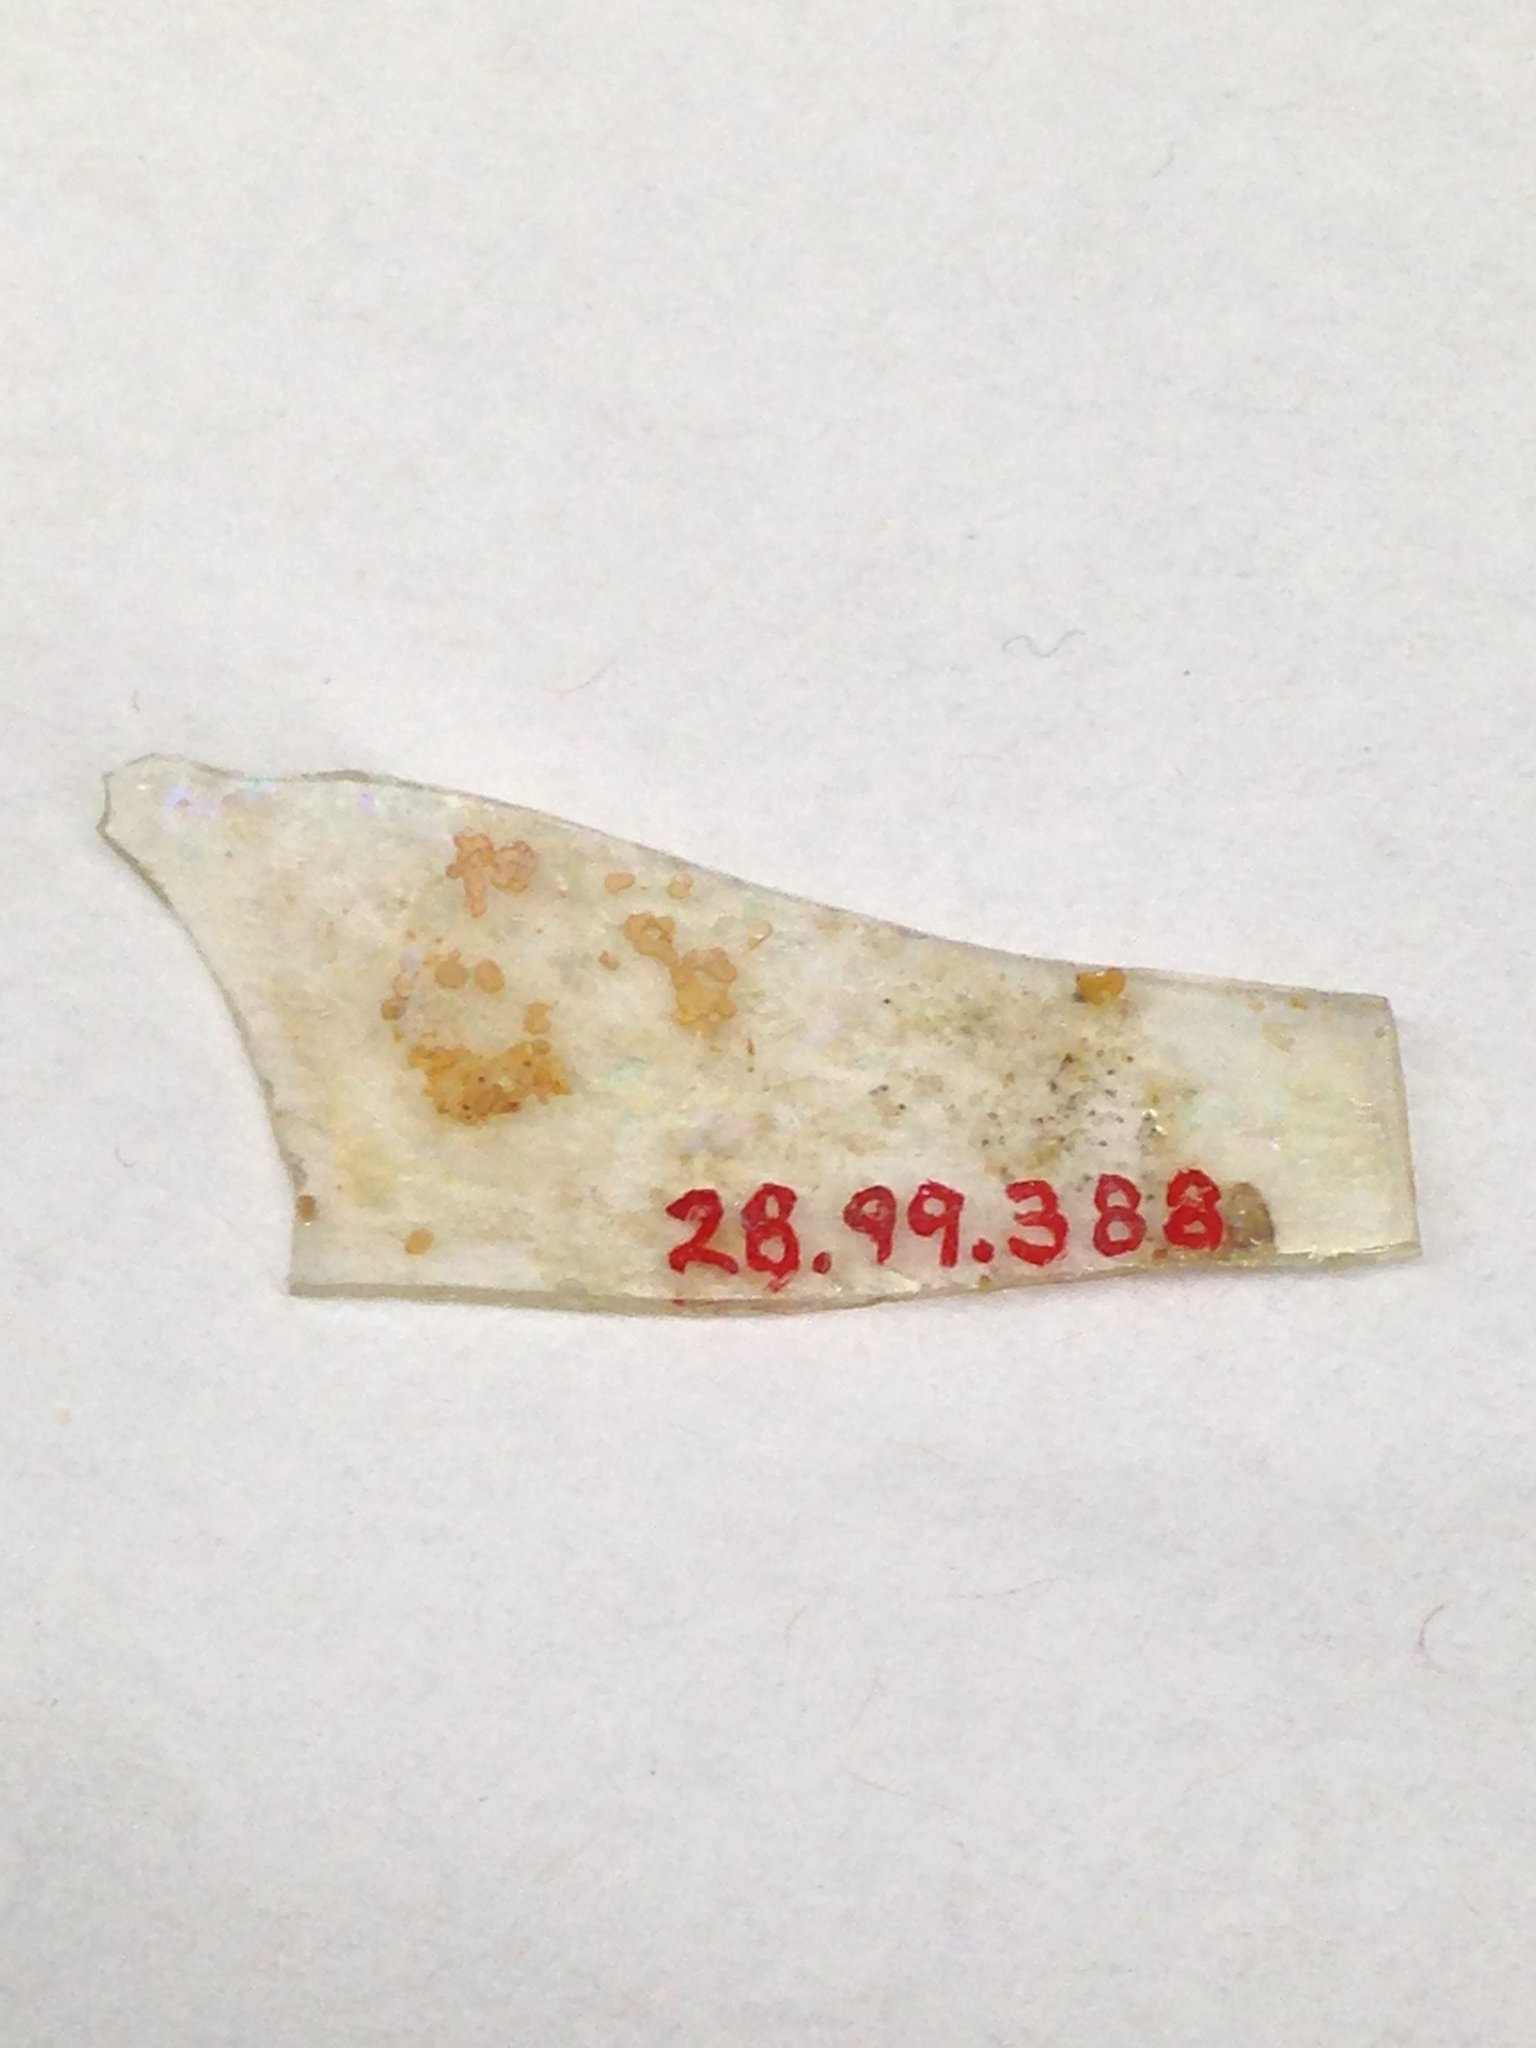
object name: fragment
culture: european or middle eastern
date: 1150-1250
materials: ceramic, glass